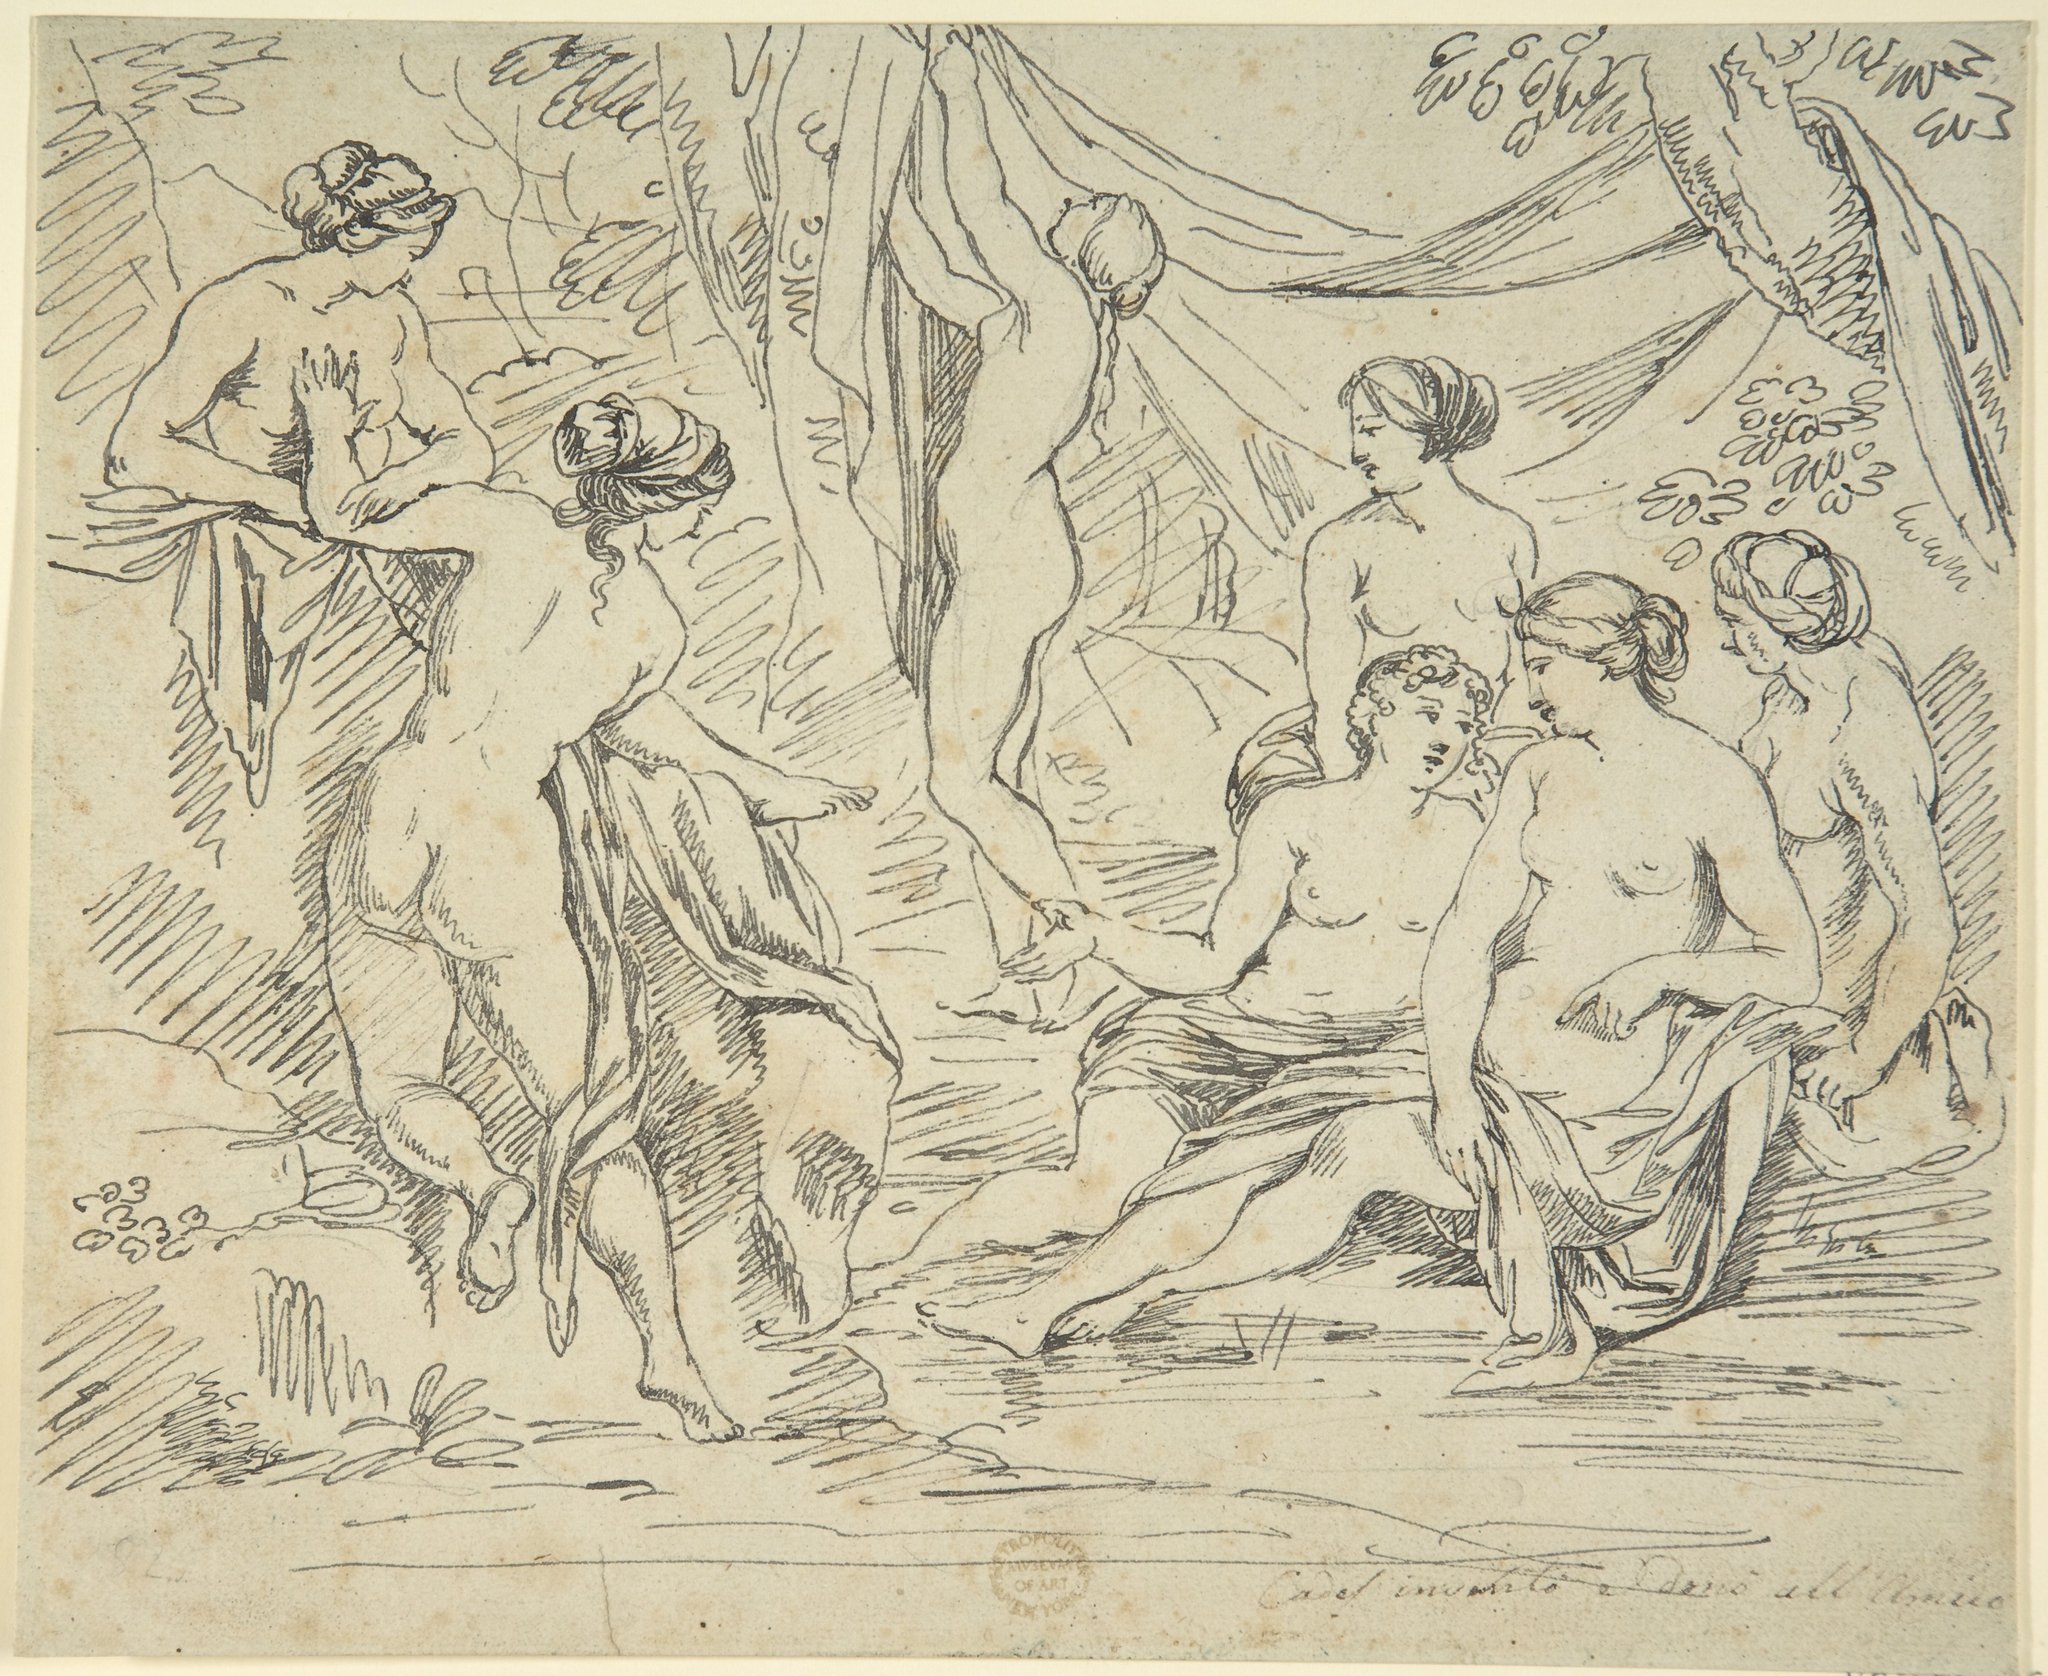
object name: drawing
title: Dianna, her Nymphs, and Callisto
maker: anonymous, italian, 19th century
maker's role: artist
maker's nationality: italian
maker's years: 1800-1900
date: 1800-1900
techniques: pen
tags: nymphs,diana